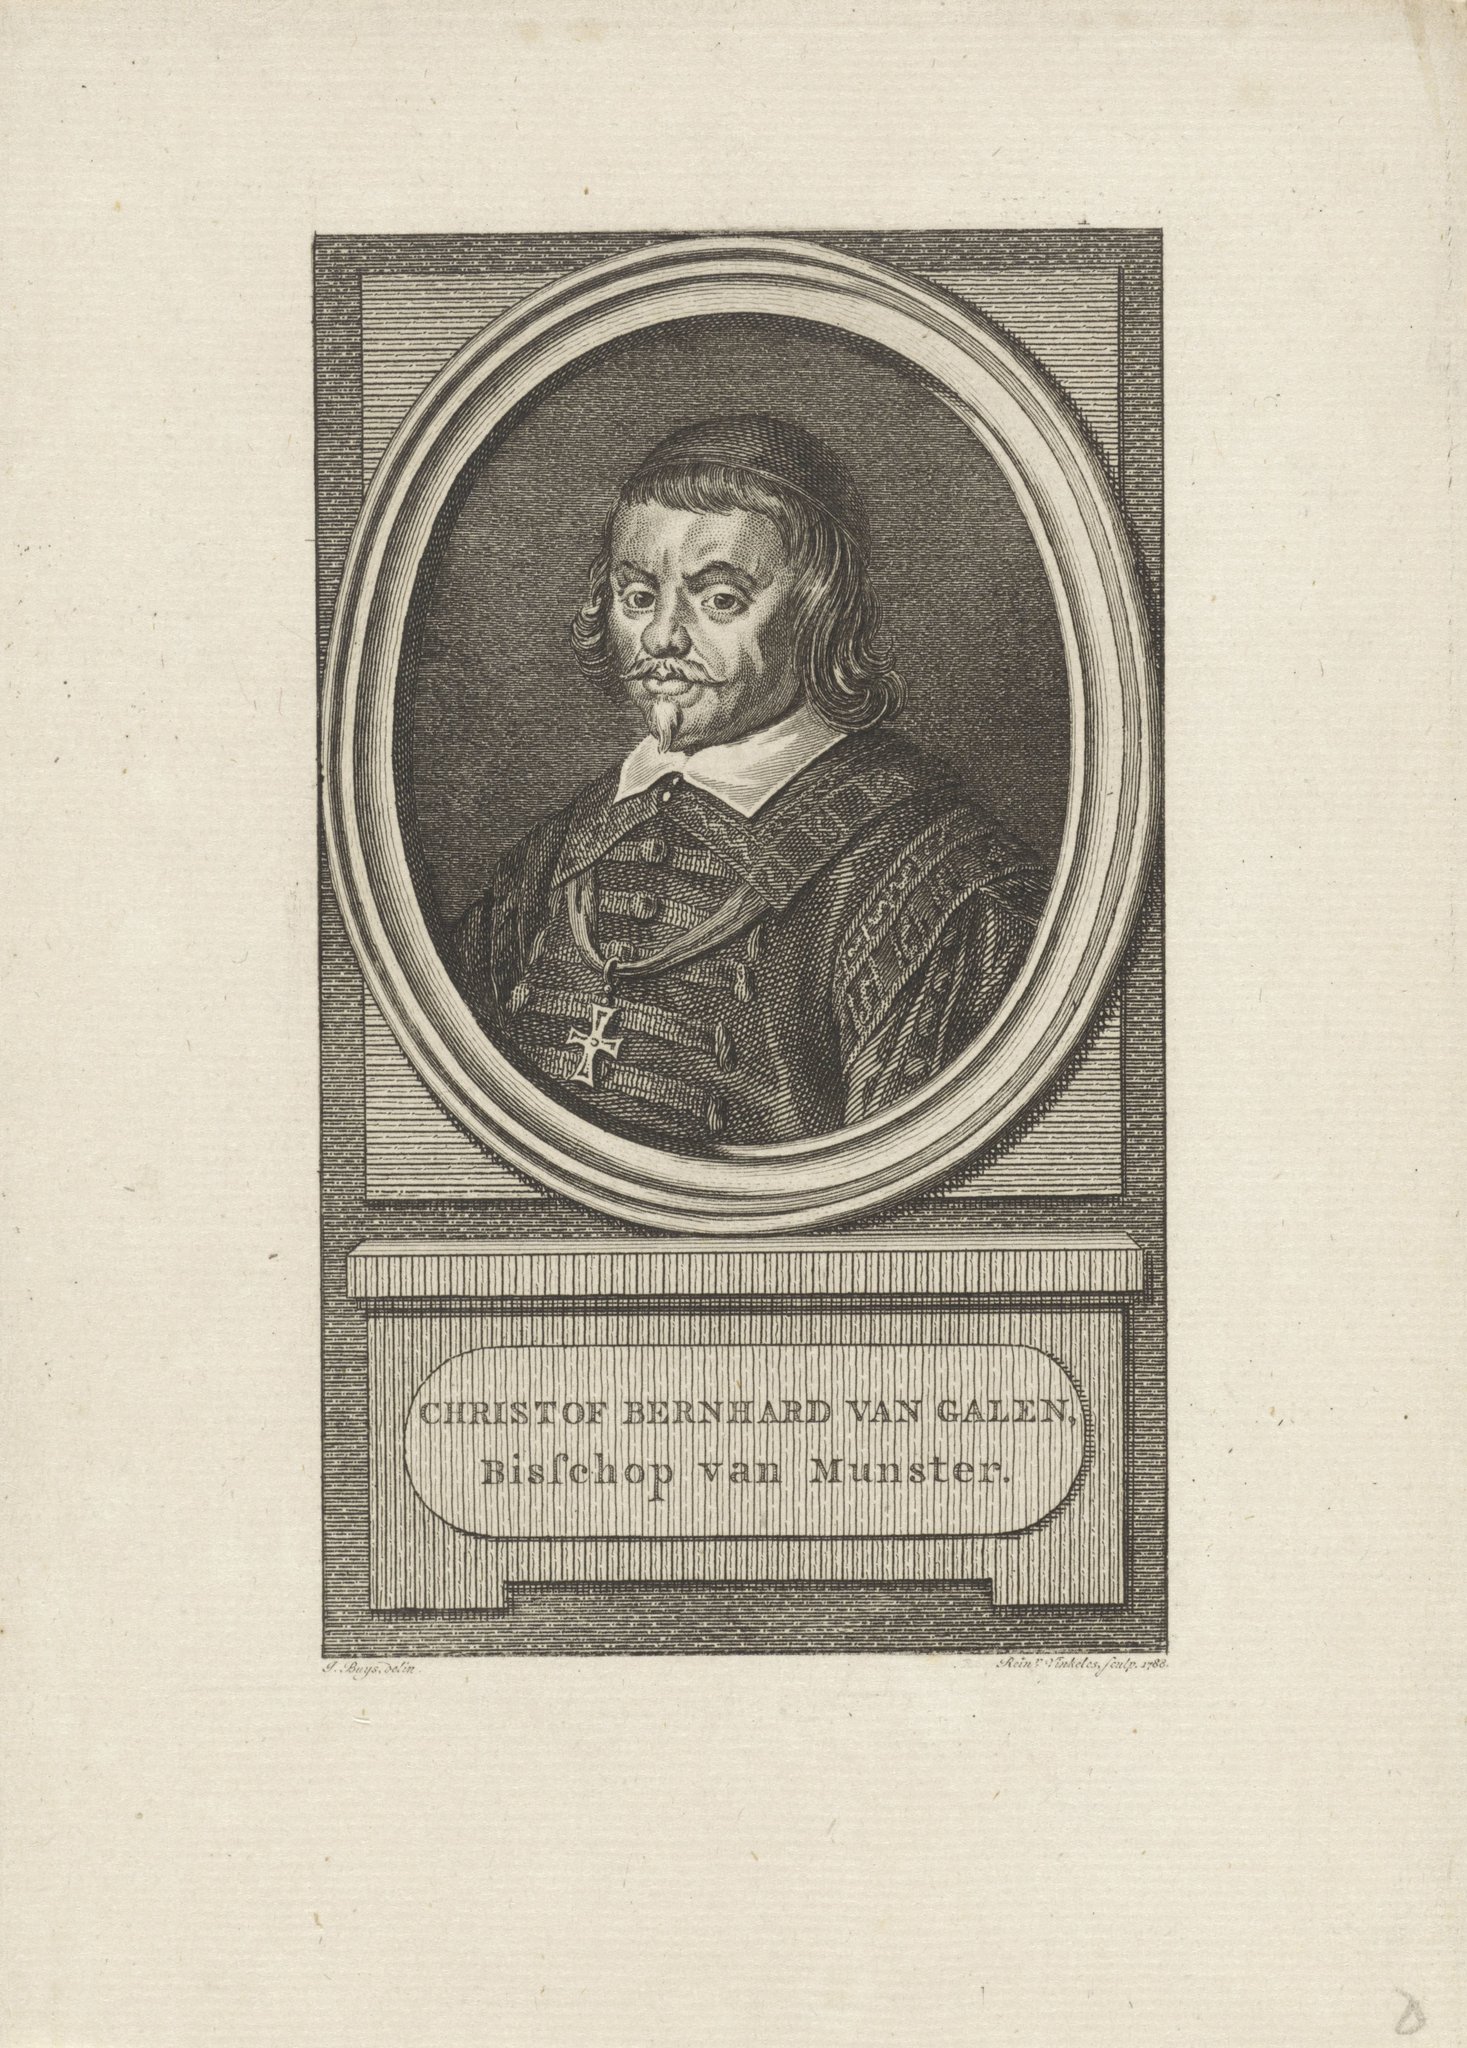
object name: print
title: Portret van Christoph Bernhard von Galen, bisschop van Münster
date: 1788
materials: paper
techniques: etching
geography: amsterdam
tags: bisschop, christoph bernhard von galen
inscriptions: collector's mark: Lugt 2233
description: Eerdere staat prent gebruikt als boekillustratie in: Kok, Jacobus. Vaderlandsch woordenboek : met kaarten, plaaten en pourtraitten. Amsterdam: Johannes Allart, 1785-1796. Deel IX.